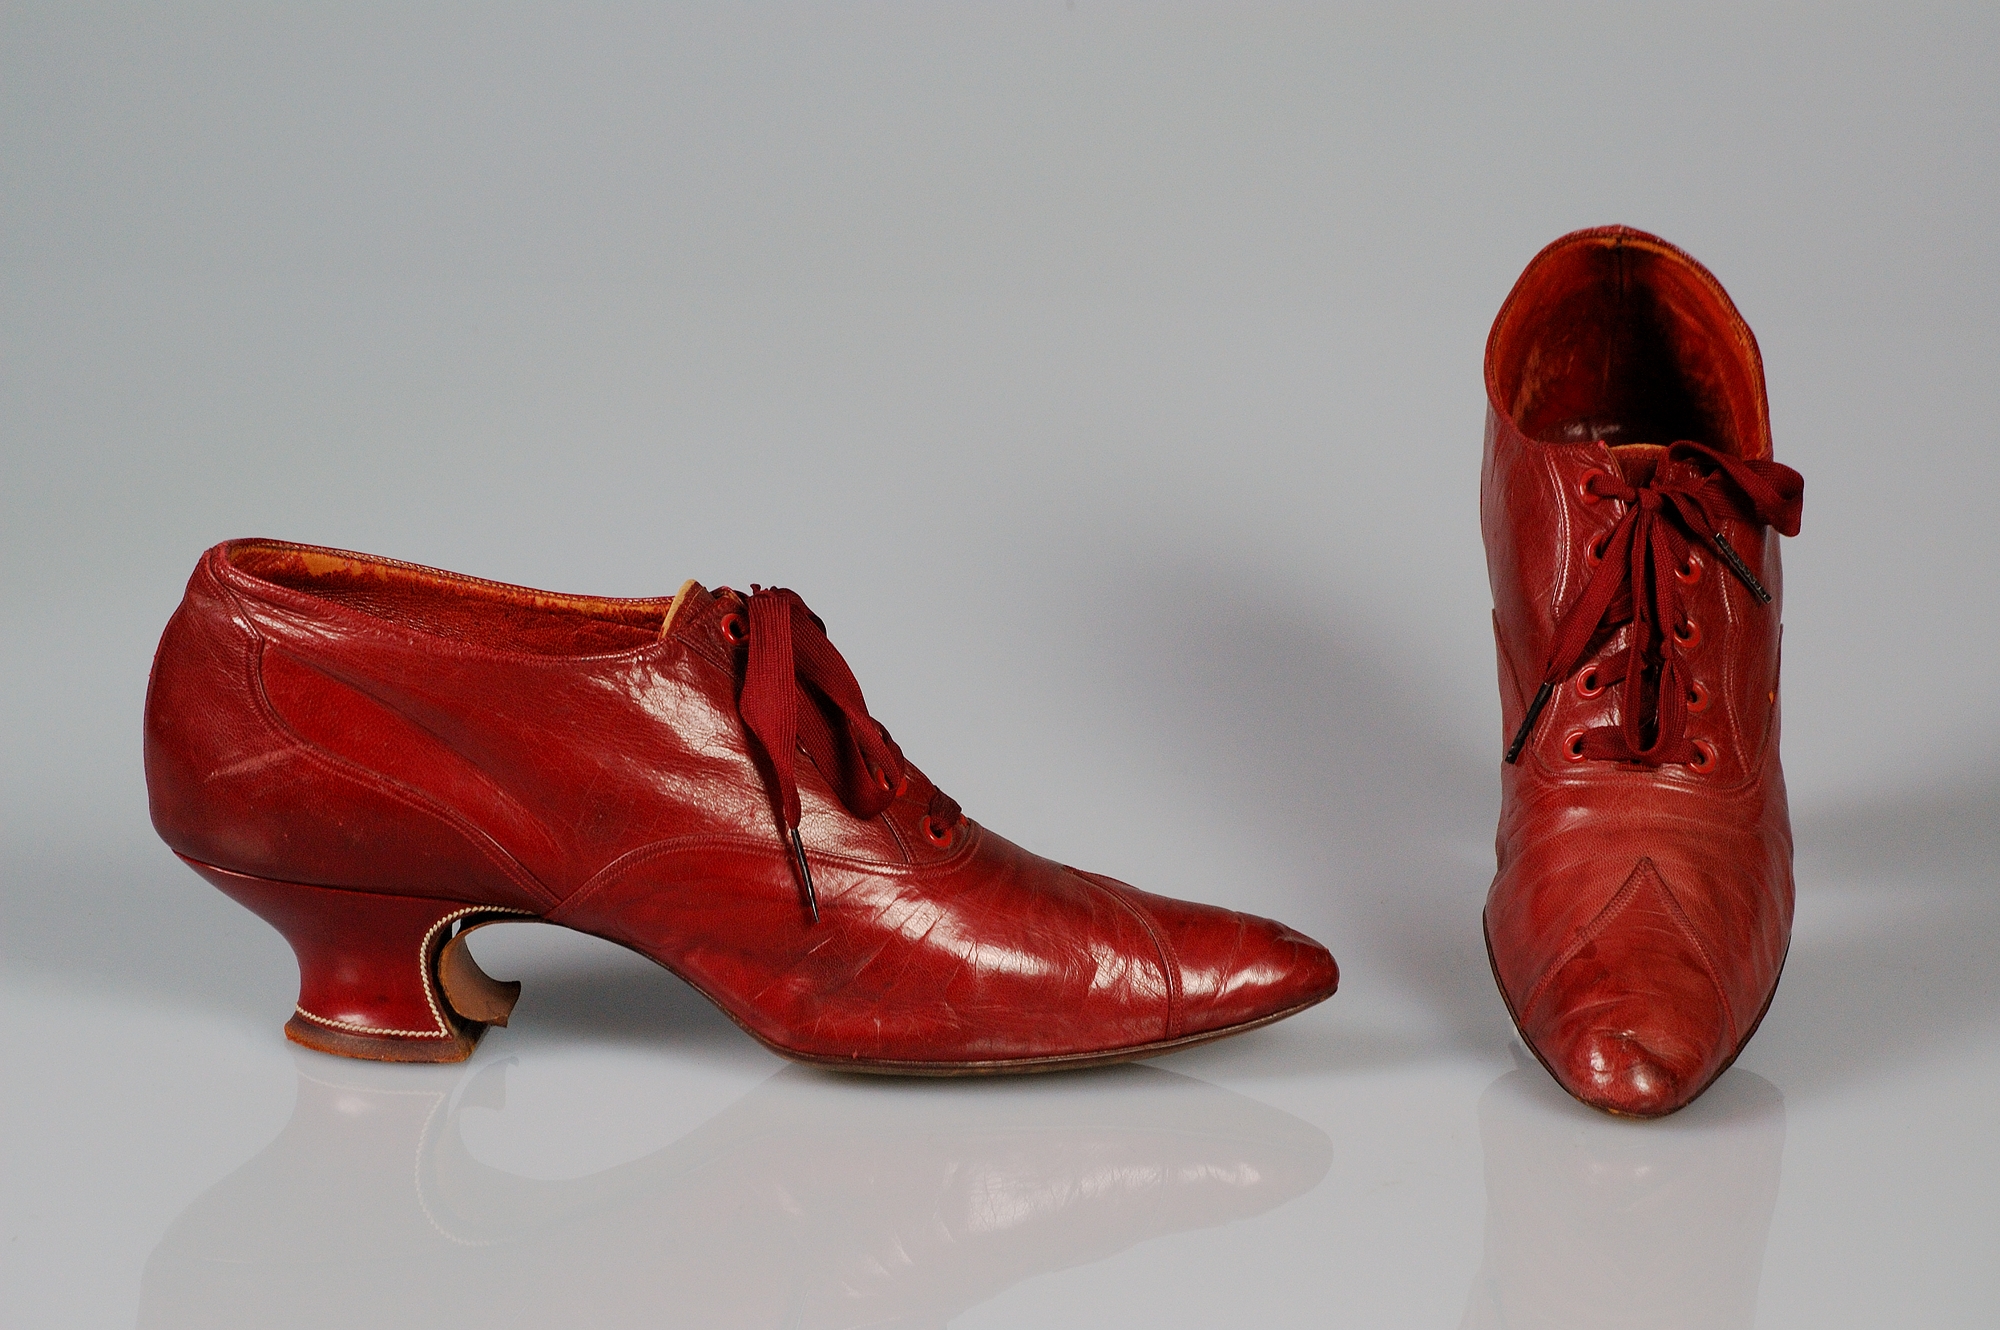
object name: oxford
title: Oxfords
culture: american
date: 1897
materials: leather